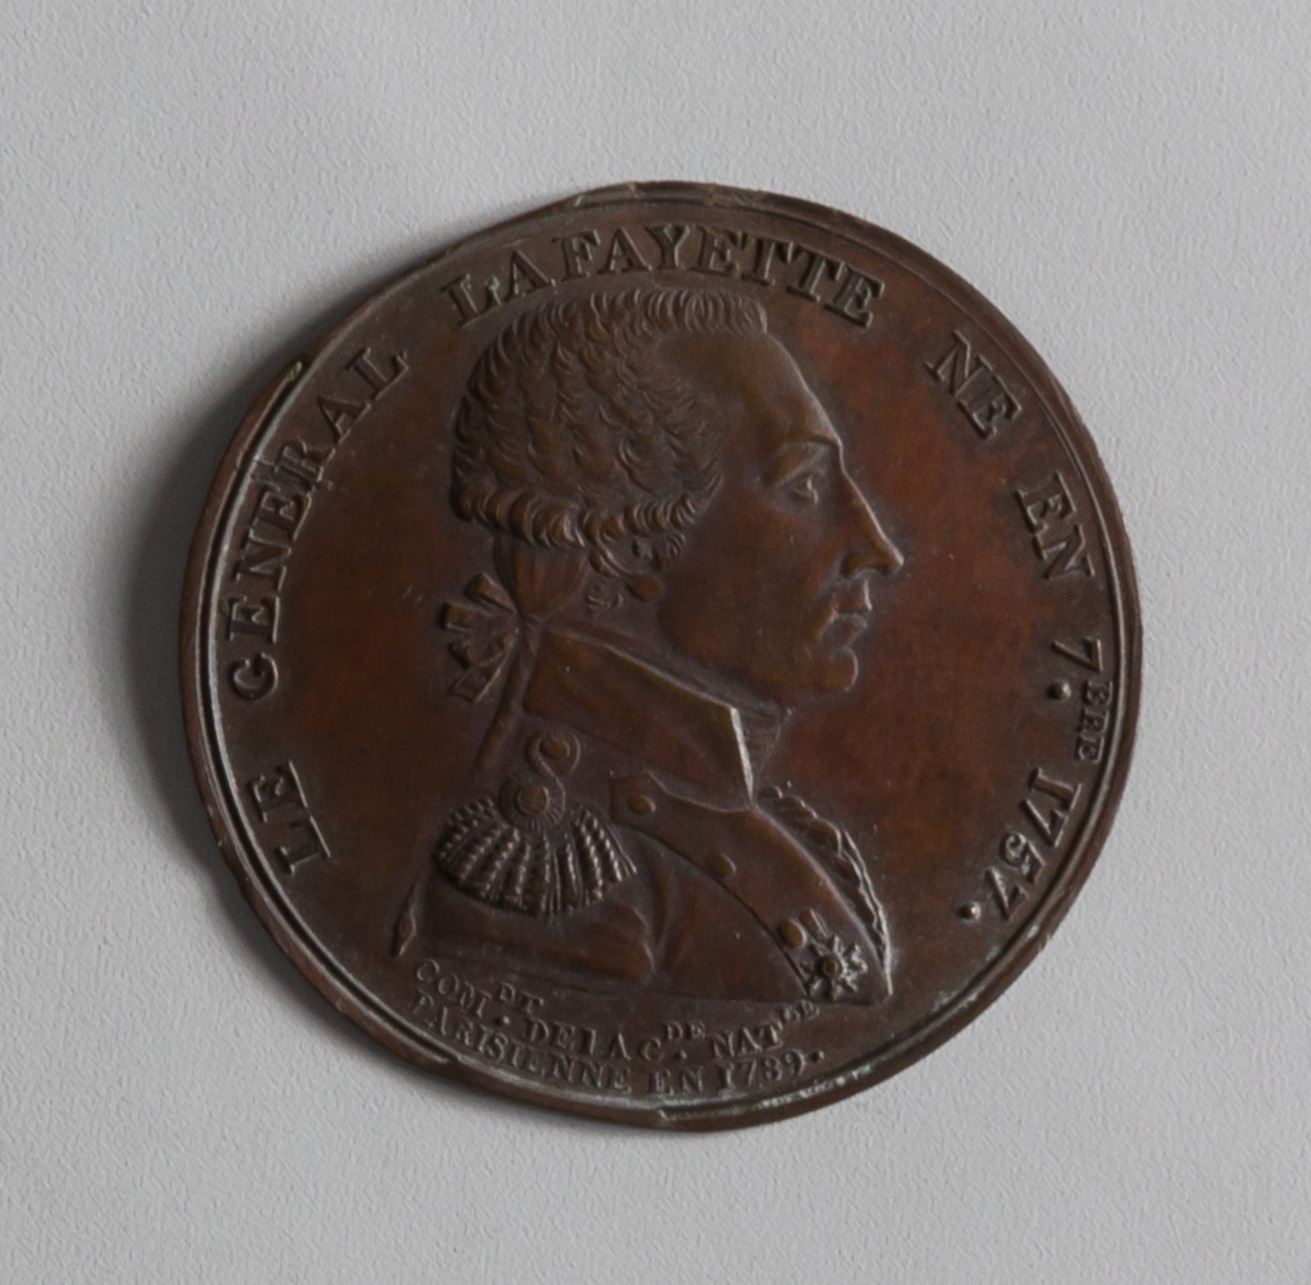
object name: medal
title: Medal of the Marquis de Lafayette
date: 1800-1883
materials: bronze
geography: france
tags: men,profiles,marquis de lafayette